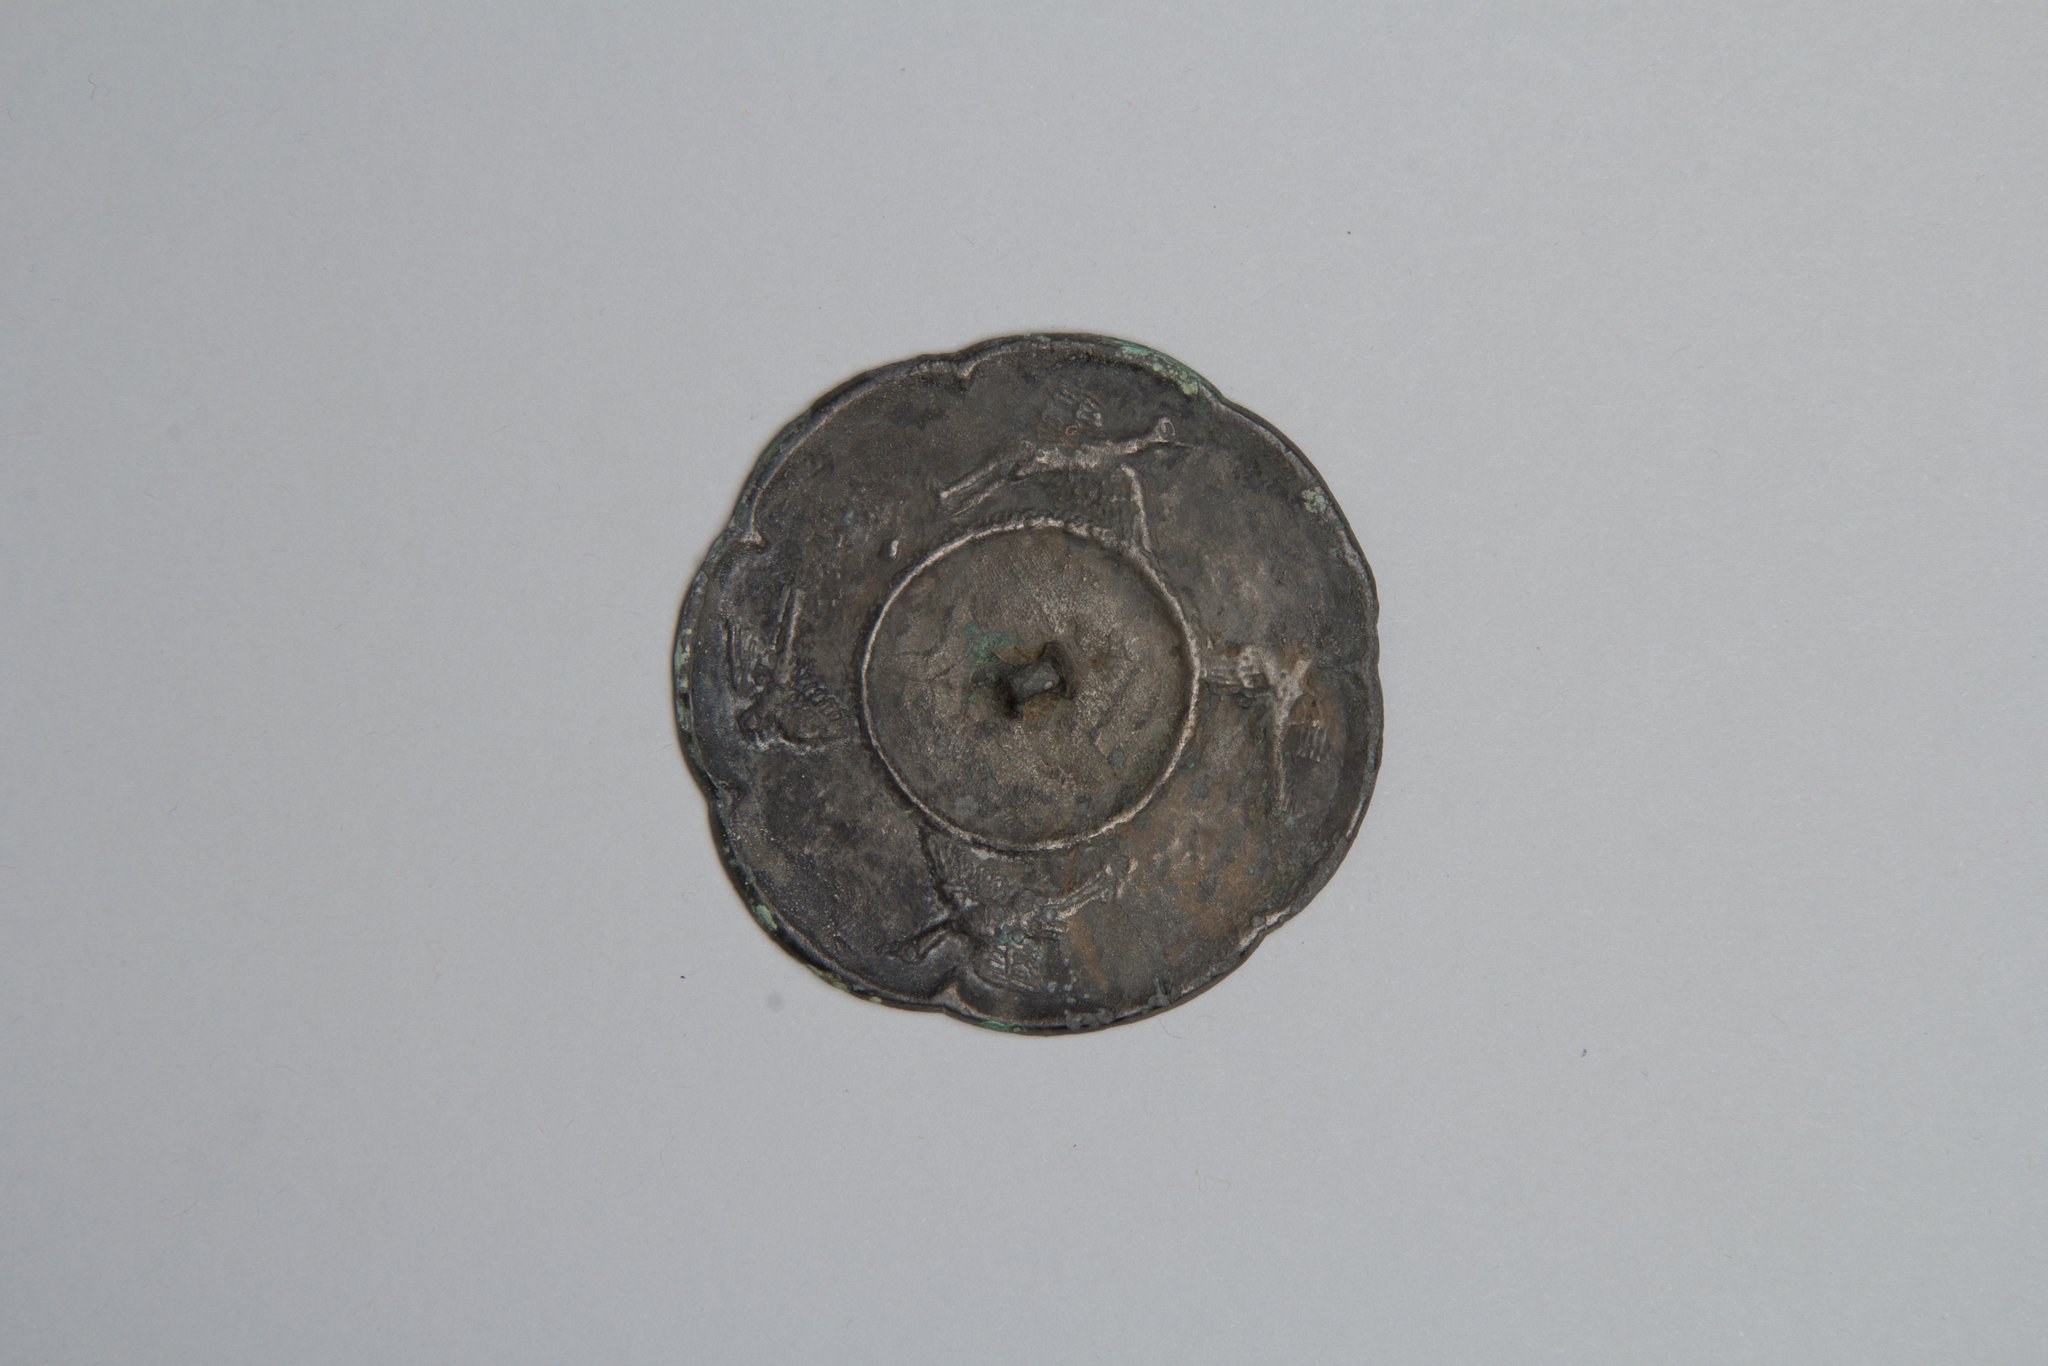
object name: mirror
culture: korean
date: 918-1392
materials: bronze